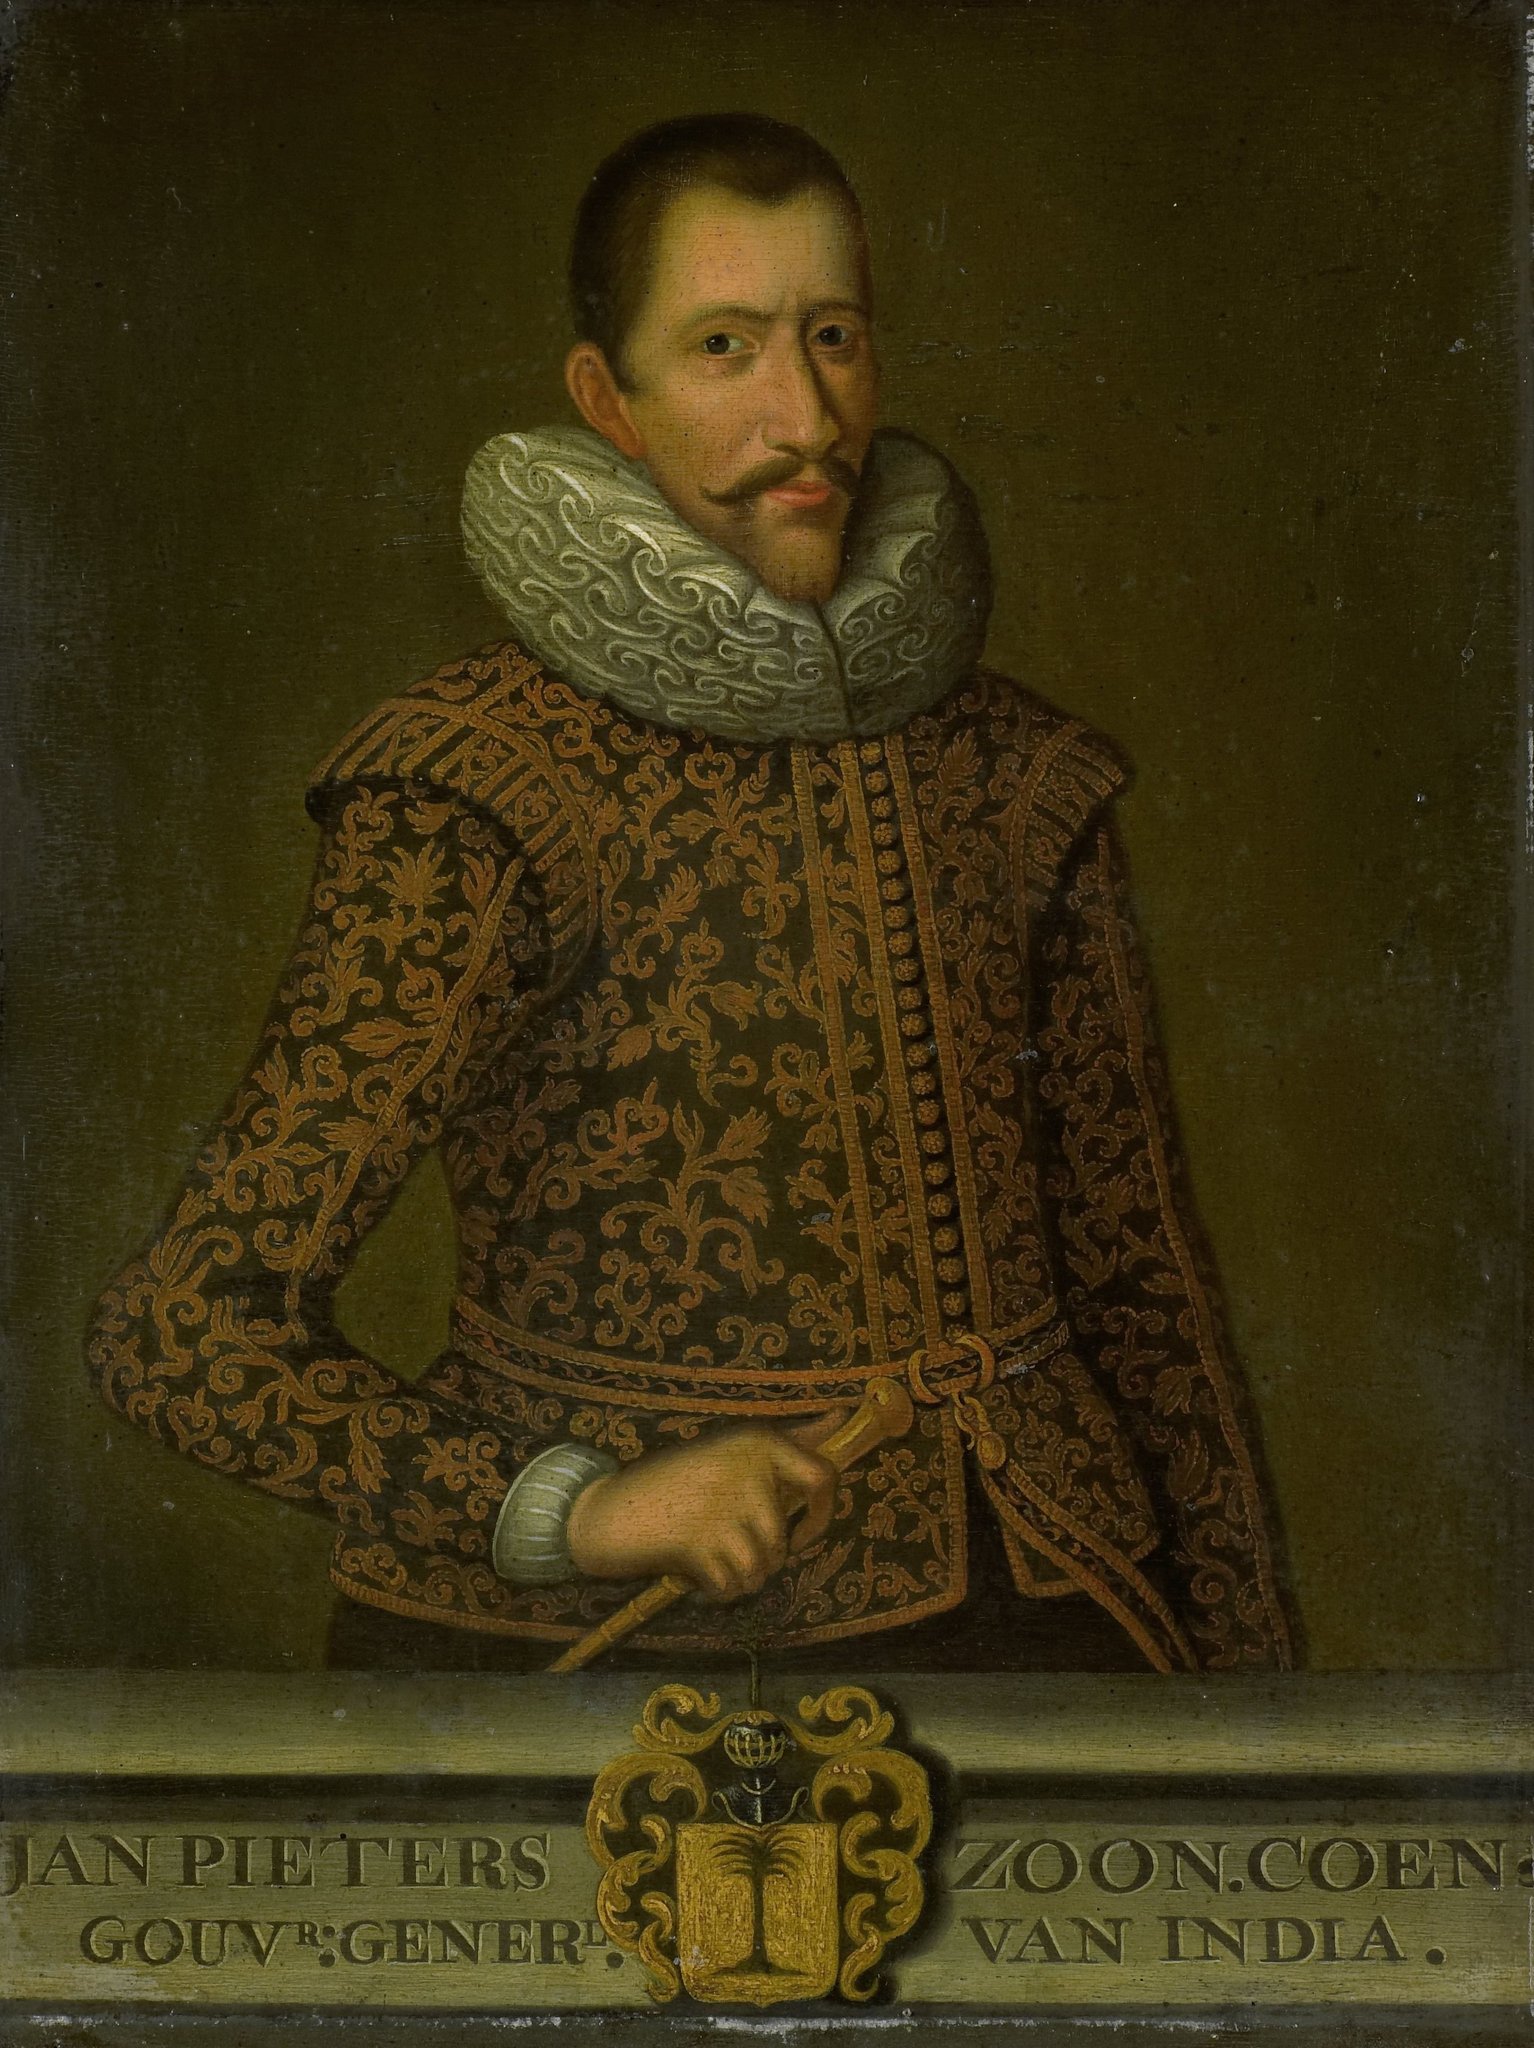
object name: painting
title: Portrait of Jan Pietersz Coen, Governor-General of the Dutch East Indies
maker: Anonymous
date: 1750-1800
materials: oil, panel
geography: batavia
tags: hoorn (north holland), batavia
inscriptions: inscription: ‘Jan Pieterszoon Coen, Gouv.r Gener.l van India.’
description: Portraits of the governors general. At the head of the VOC administration in Asia was the governor general, the chairman of the East Indies Council, which met in Batavia. The Council's assembly chamber at the Castle in Batavia was the focal point of Dutch power. Along the walls hung the portraits of all the past governors general, symbolising the continuity of the Dutch presence. Smaller copies at the Company's offices in the Netherlands represented the VOC's power in Asia. The copies displayed here probably come from the VOC's Rotterdam Chamber. Some of the portraits from the series that hung in Batavia are displayed above in the VOC gallery that circles this room. Pieter Both, 1610-1614 Gerard Reynst, 1614-1615 Laurens Reael,1615-1619 Jan Pietersz Coen, 1619-1623 and 1627-1629 Pieter de Carpentier, 1623-1627 Jacques Specx, 1629-1632 Hendrick Brouwer, 1632-1636 Antonio van Diemen, 1636-1645 Cornelis van der Lijn, 1645-1650 Karel Reiniersz, 1650-1653 Joan Maetsuycker, 1653-1678 Rycklof van Goens, 1678-1681 Cornelis Speelman, 1681-1684 Johannes Camphuys, 1684-1691 Willem van Outshoorn, 1691-1704 Abraham van Riebeeck, 1709-1713 Christoffel van Swoll, 1713-1718 Hendrick Zwaardecroon, 1718-1725 Mattheus de Haan, 1725-1729 The portrait of Joan van Hoorn, 1704-1709, is missing.